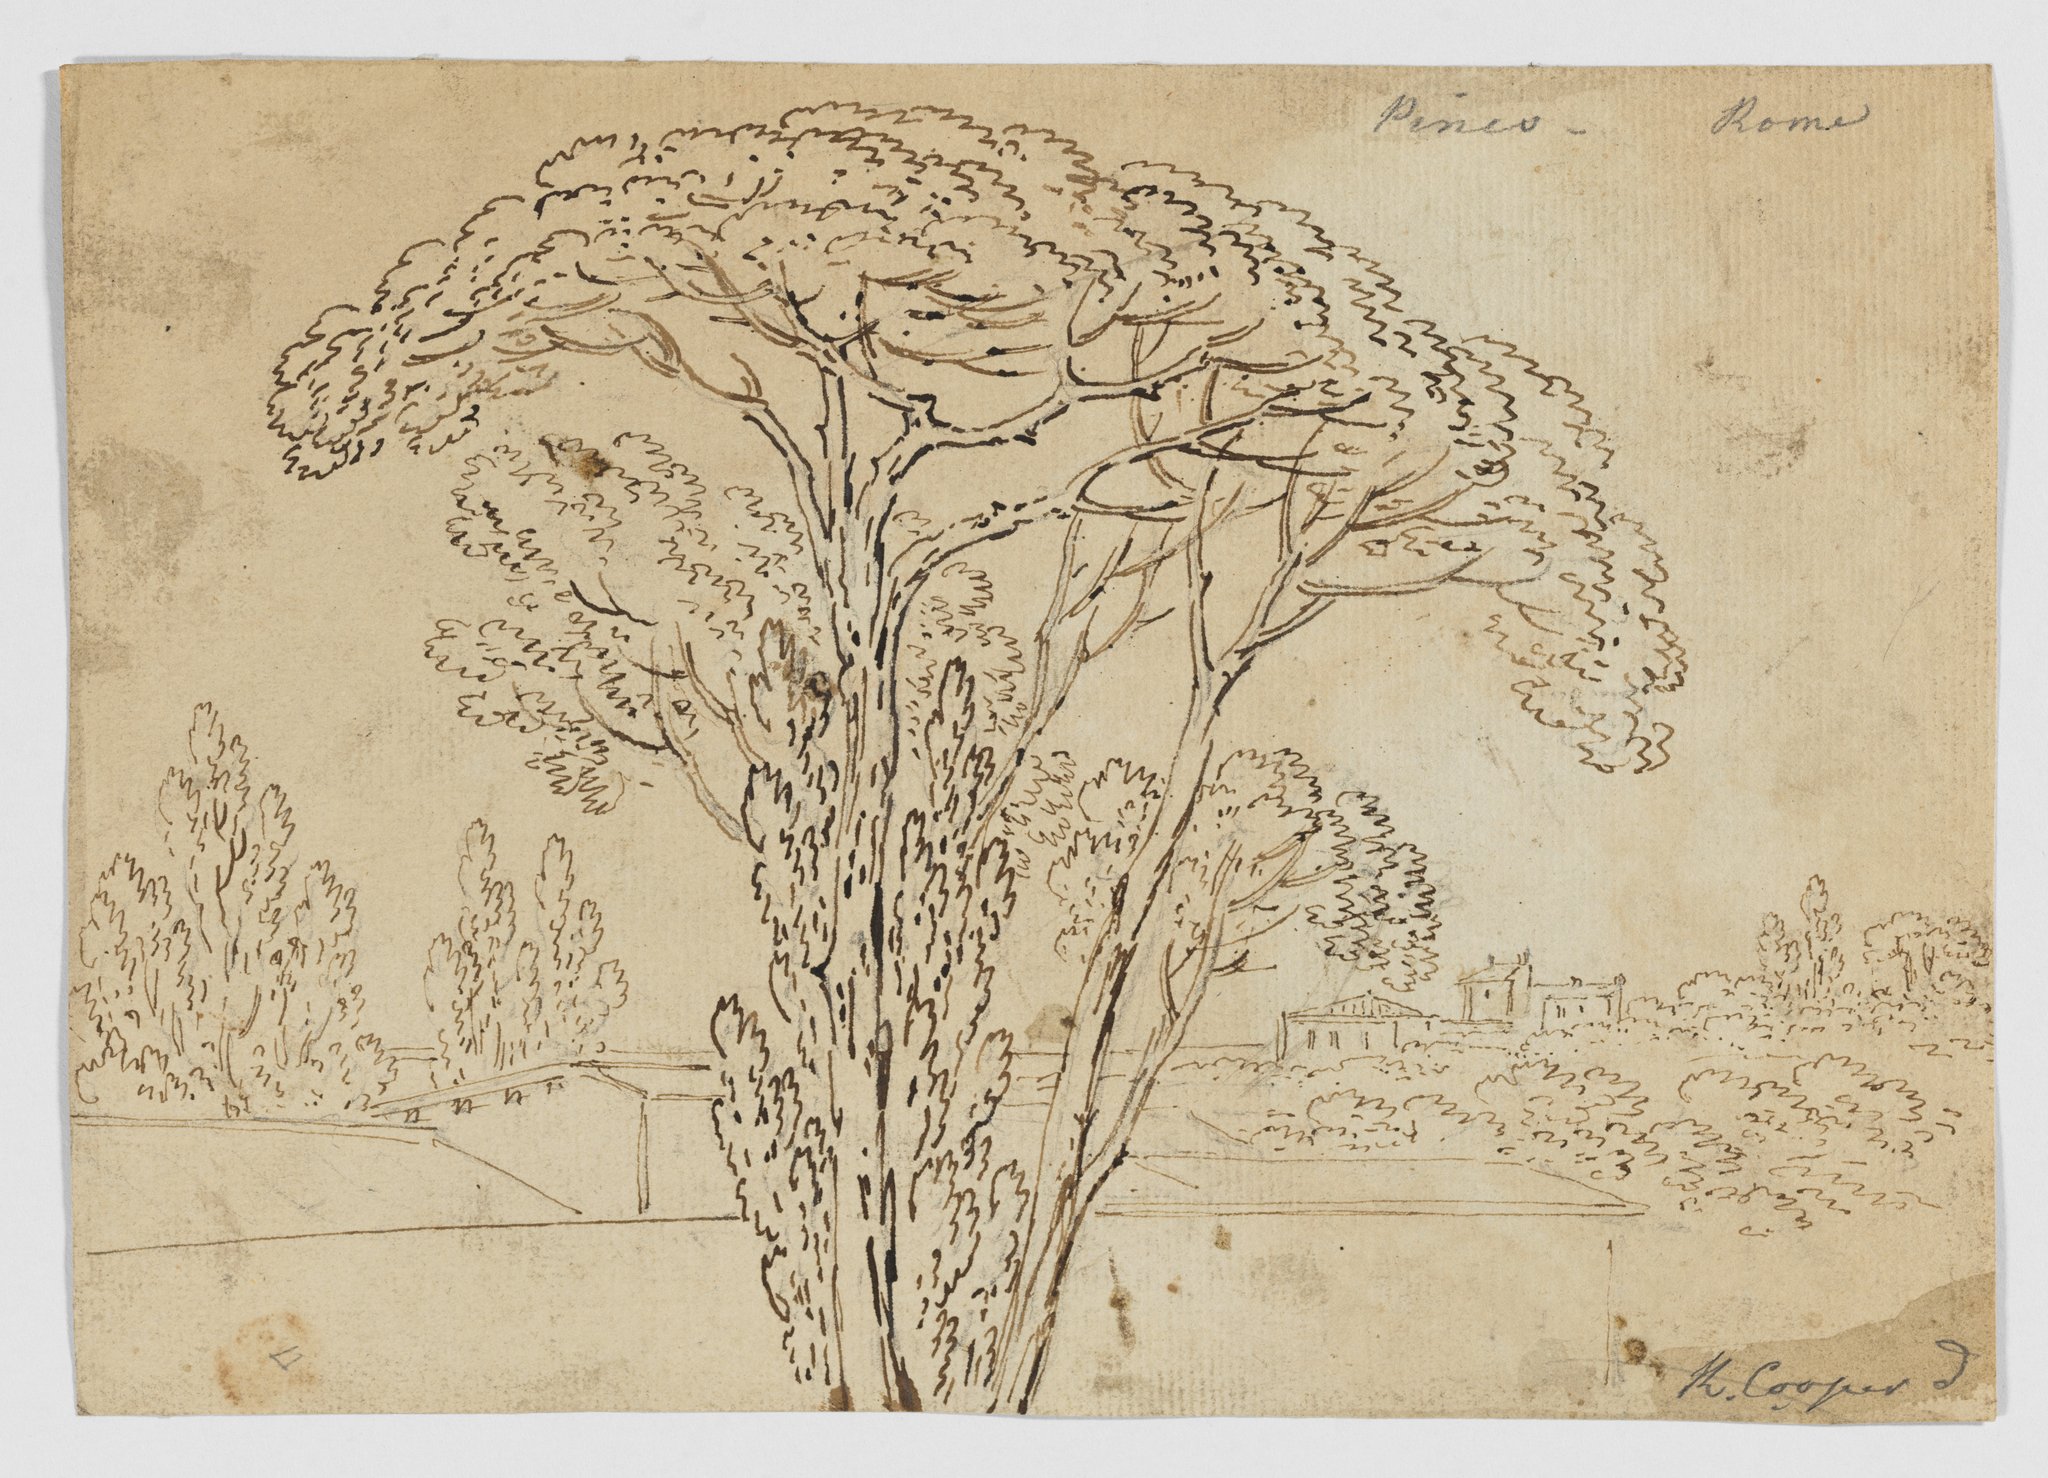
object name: drawing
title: Pinco Rome (Roman Pines) (recto), Foliage sketches (verso)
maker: richard cooper ii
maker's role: artist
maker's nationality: british, scottish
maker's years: 1740-1822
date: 1774-1775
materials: graphite, ink, iron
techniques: pen, wash